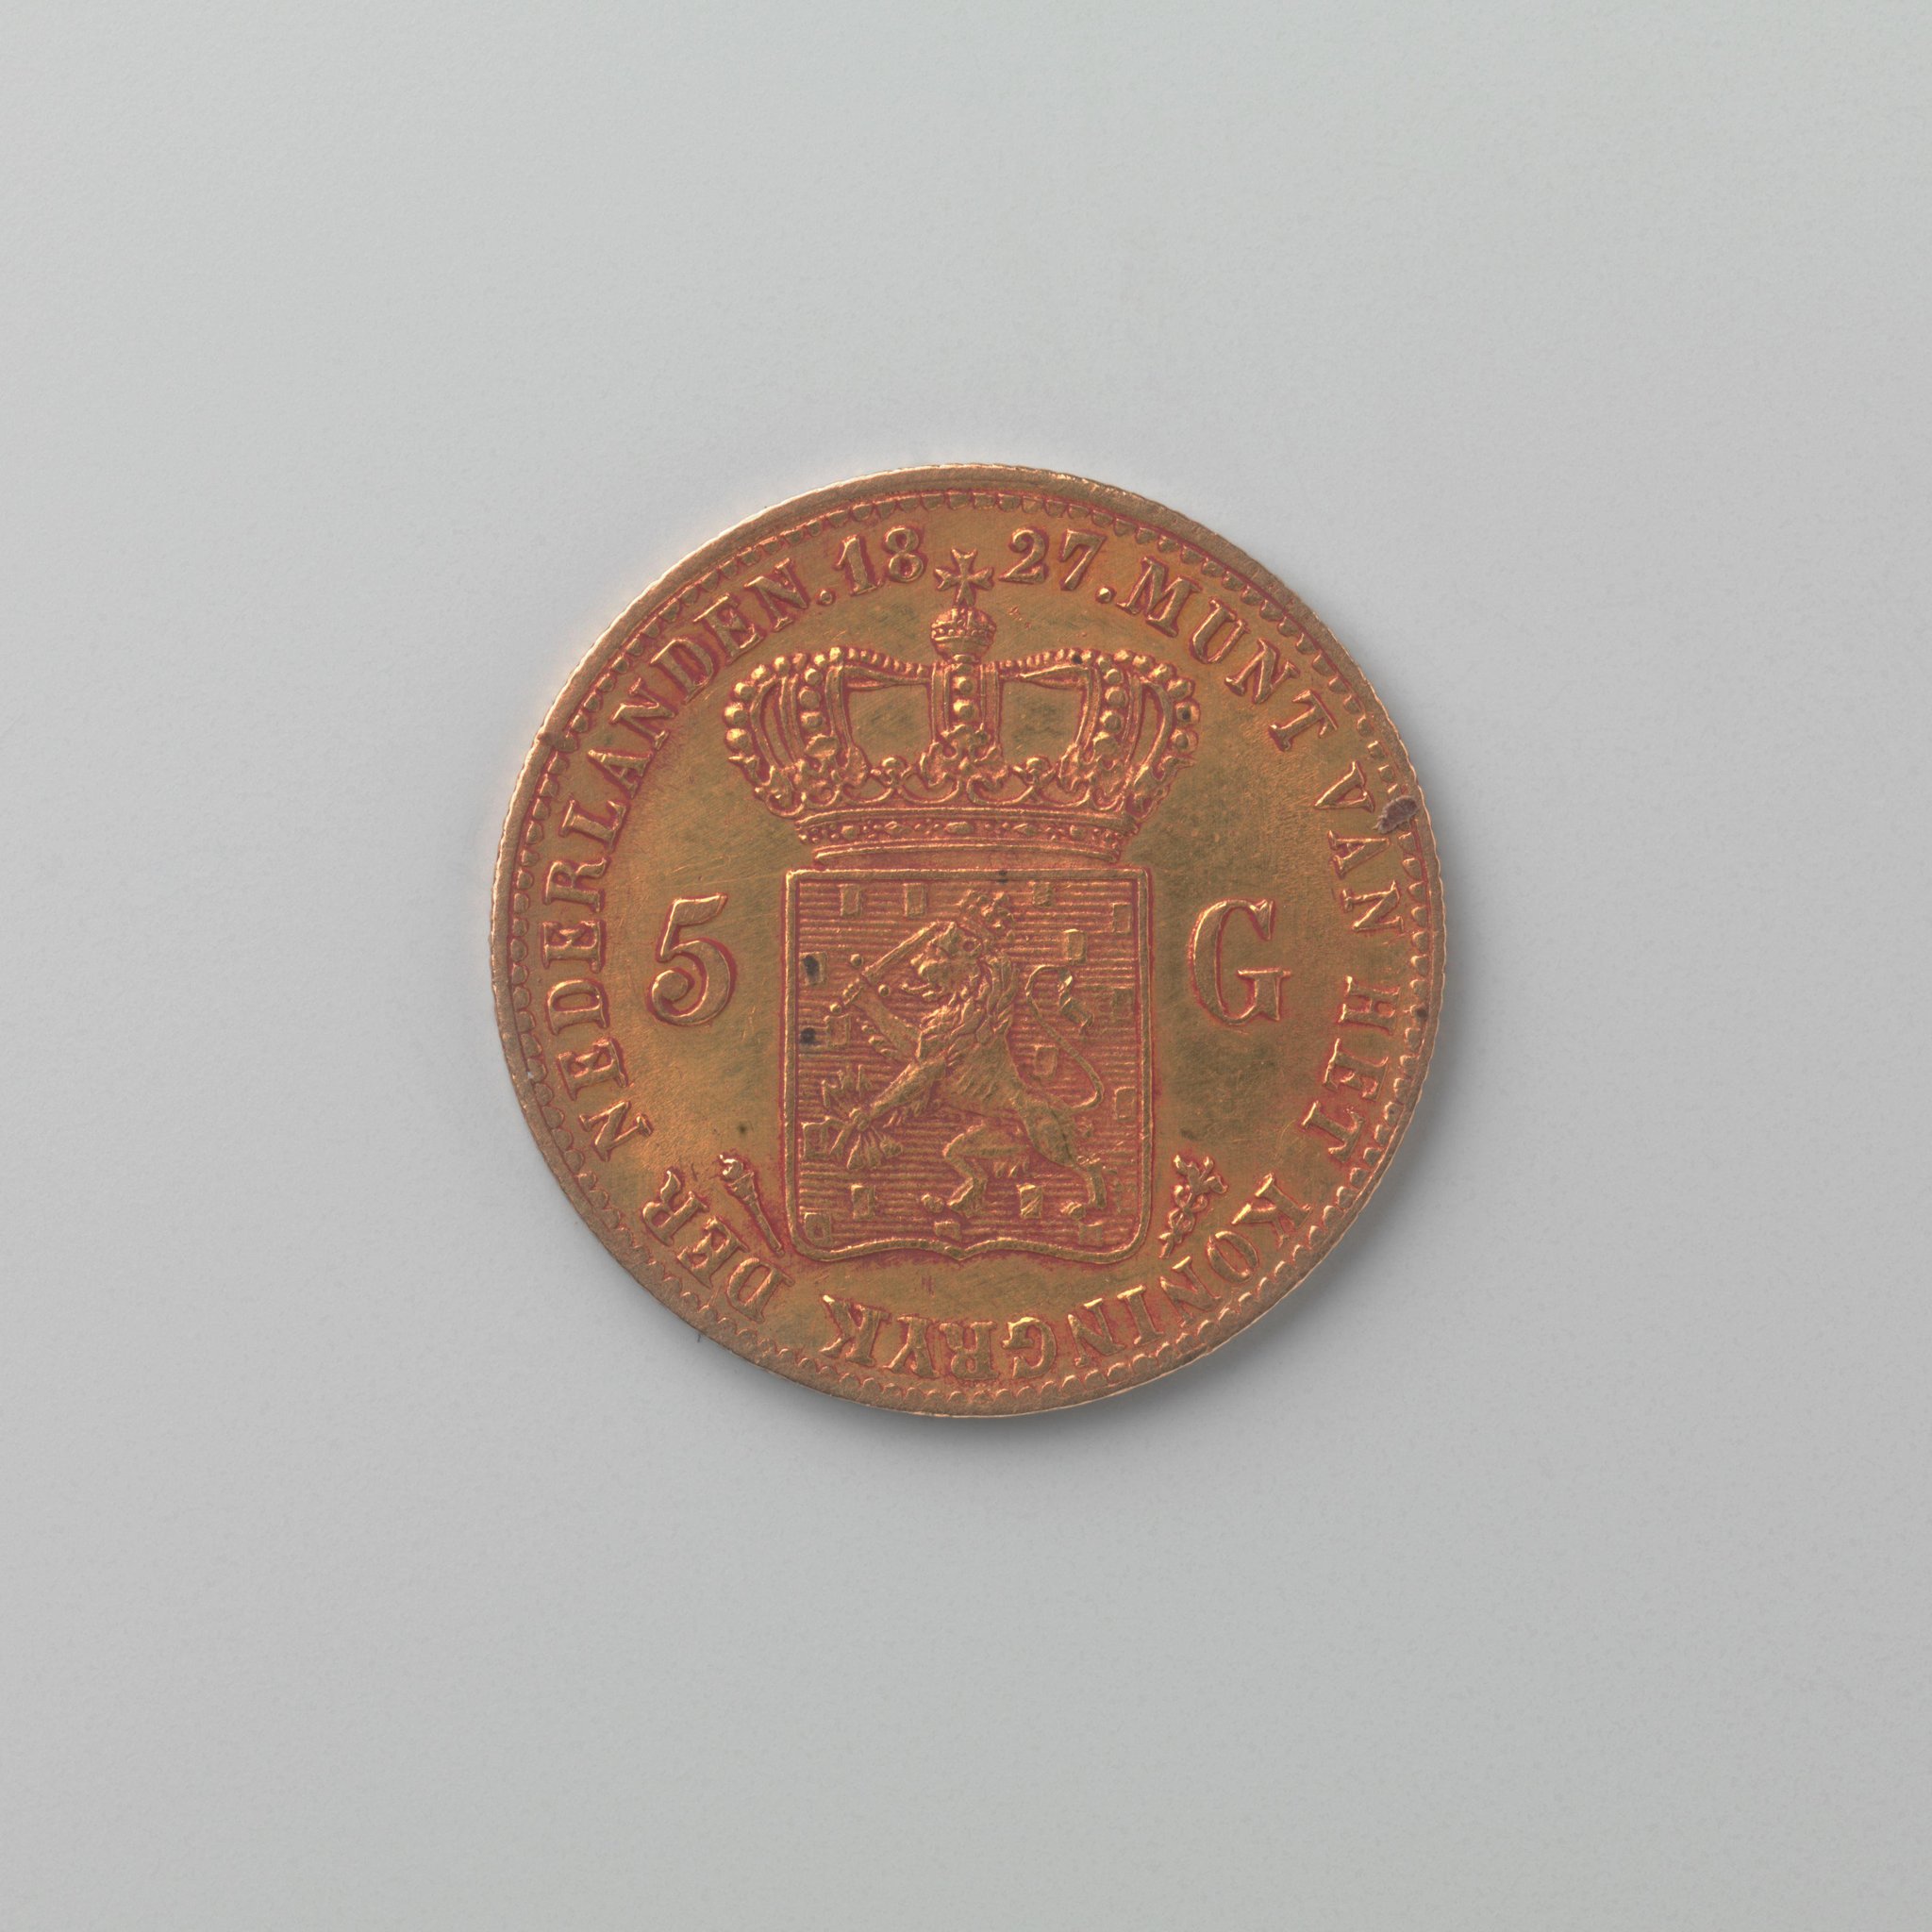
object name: coin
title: Nederlandse ½ cent, 1850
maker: willem iii (koning der nederlanden)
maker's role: koning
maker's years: 1817-1890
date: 1850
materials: copper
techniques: striking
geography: utrecht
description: Koperen munt. Voorzijde: tussen jaartal gekroonde rechte letter W. Keerzijde: tussen waarde-aanduiding ½ C. gekroond rijkswapenschild. Gladde rand.